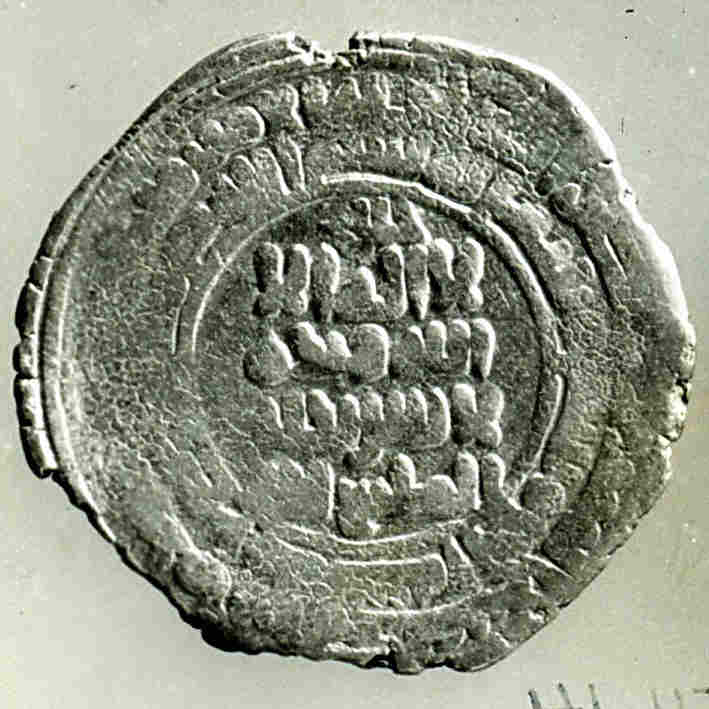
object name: coin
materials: silver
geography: jurjan